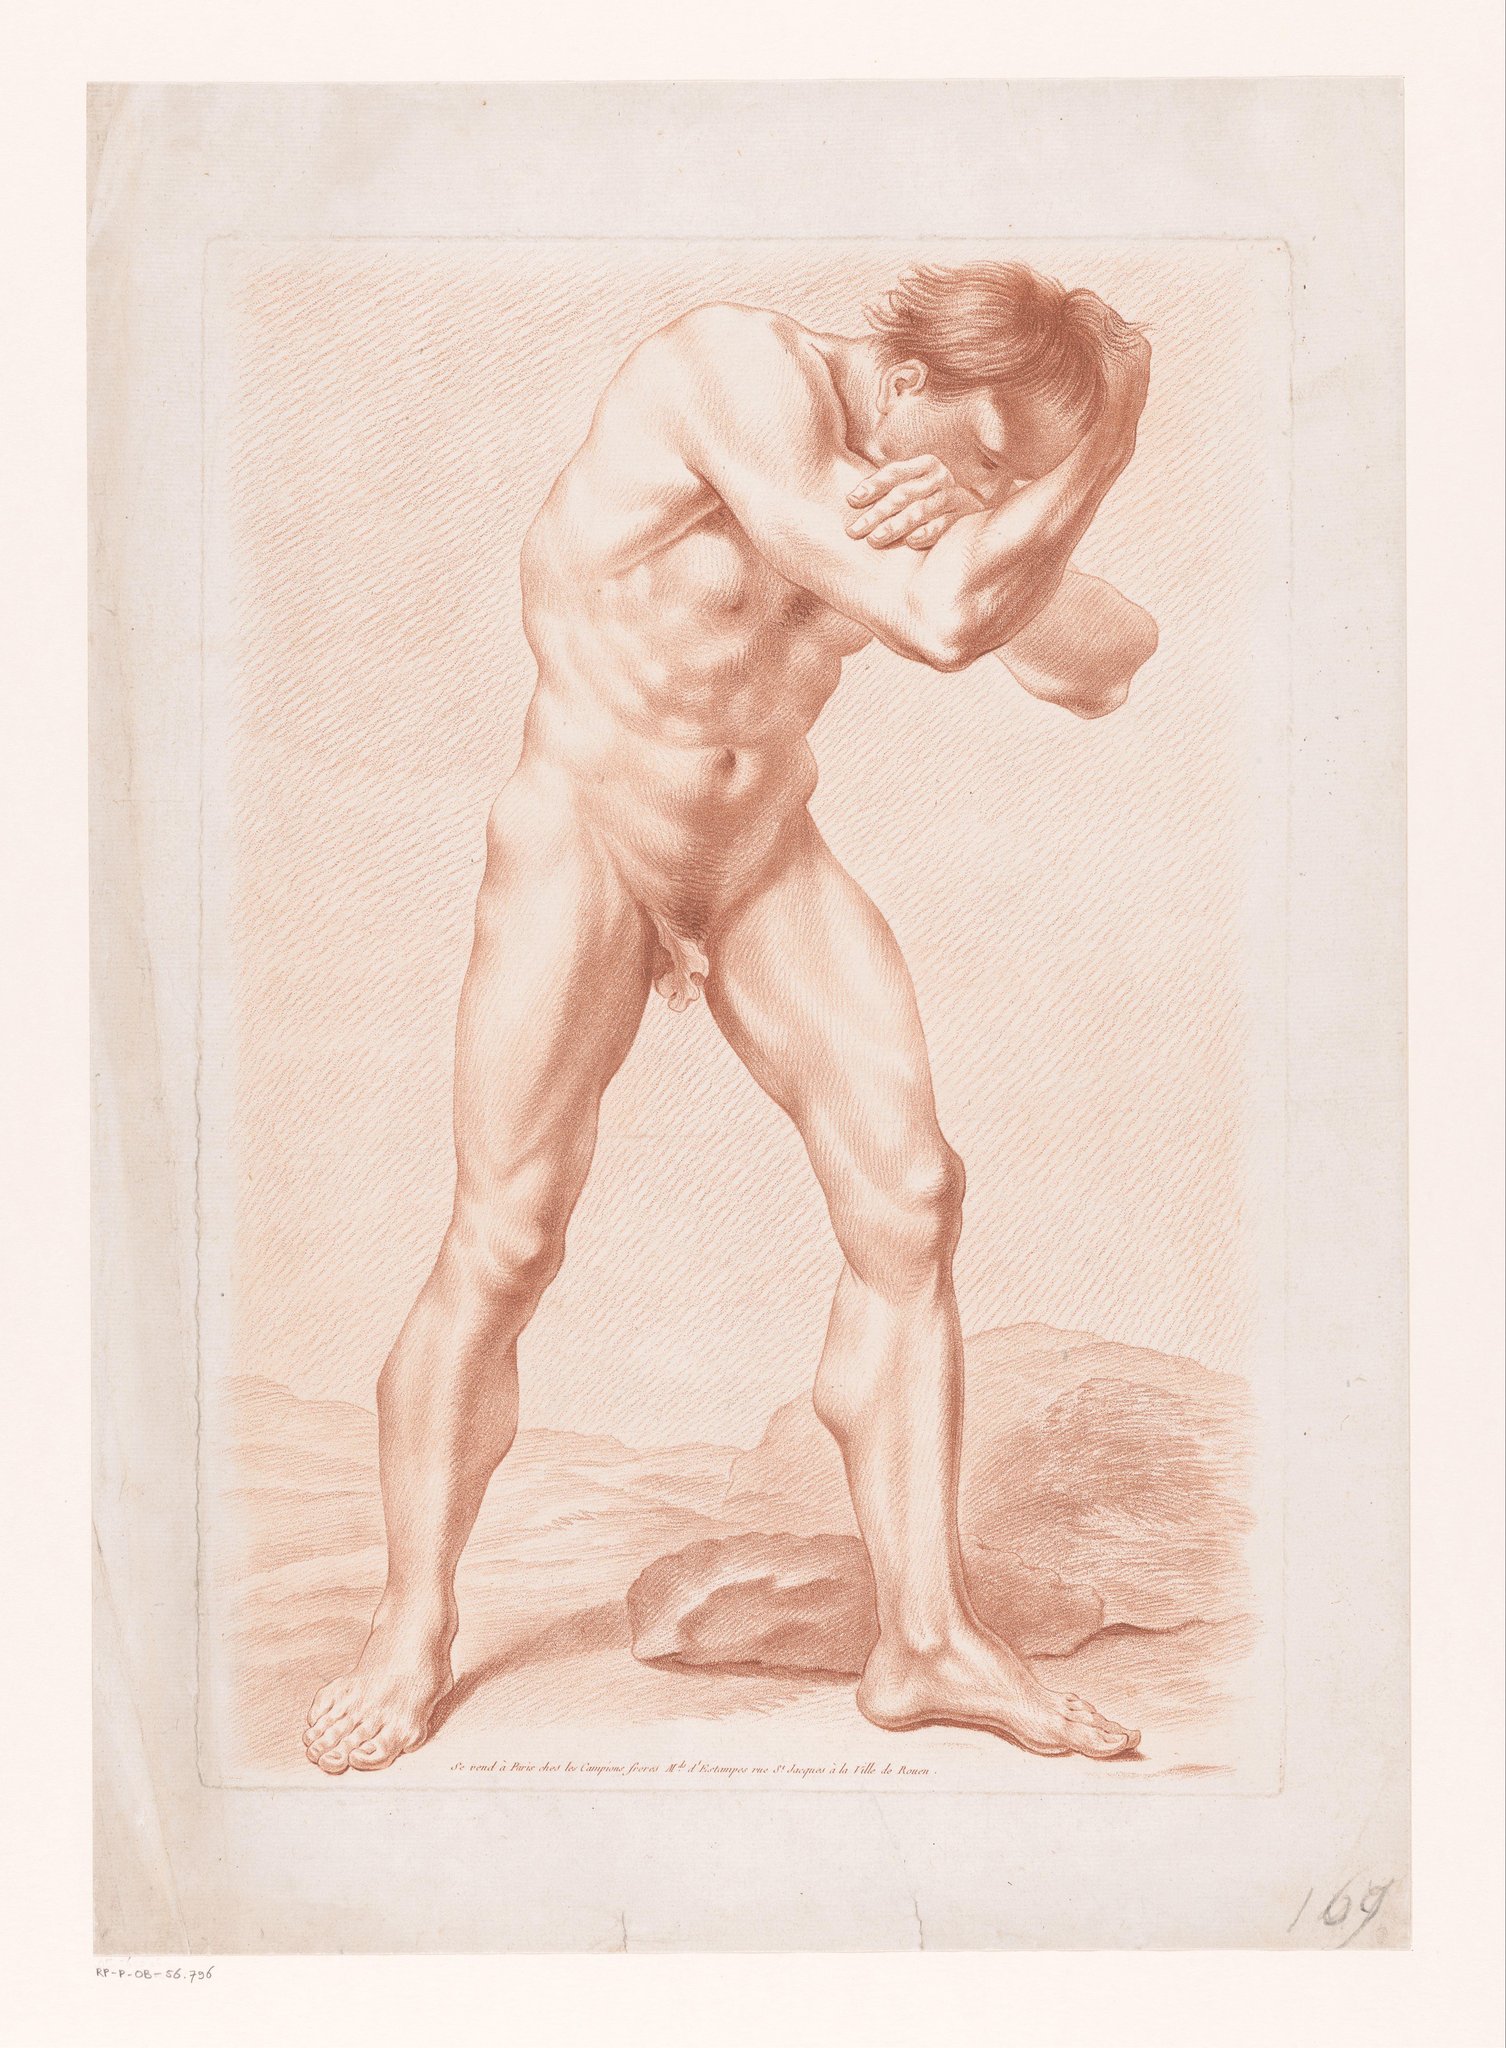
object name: print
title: Staande naakte man met armen rond zijn hoofd gevouwen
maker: louis marin bonnet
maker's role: print maker, publisher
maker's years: 1736-1793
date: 1769-1790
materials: paper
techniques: printmaking, engraving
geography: paris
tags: human figure of ideal proportions, e.g. academic nude, male sex; man, man (showing himself) undressed, quasi-nude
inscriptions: collector's mark: Lugt 2228